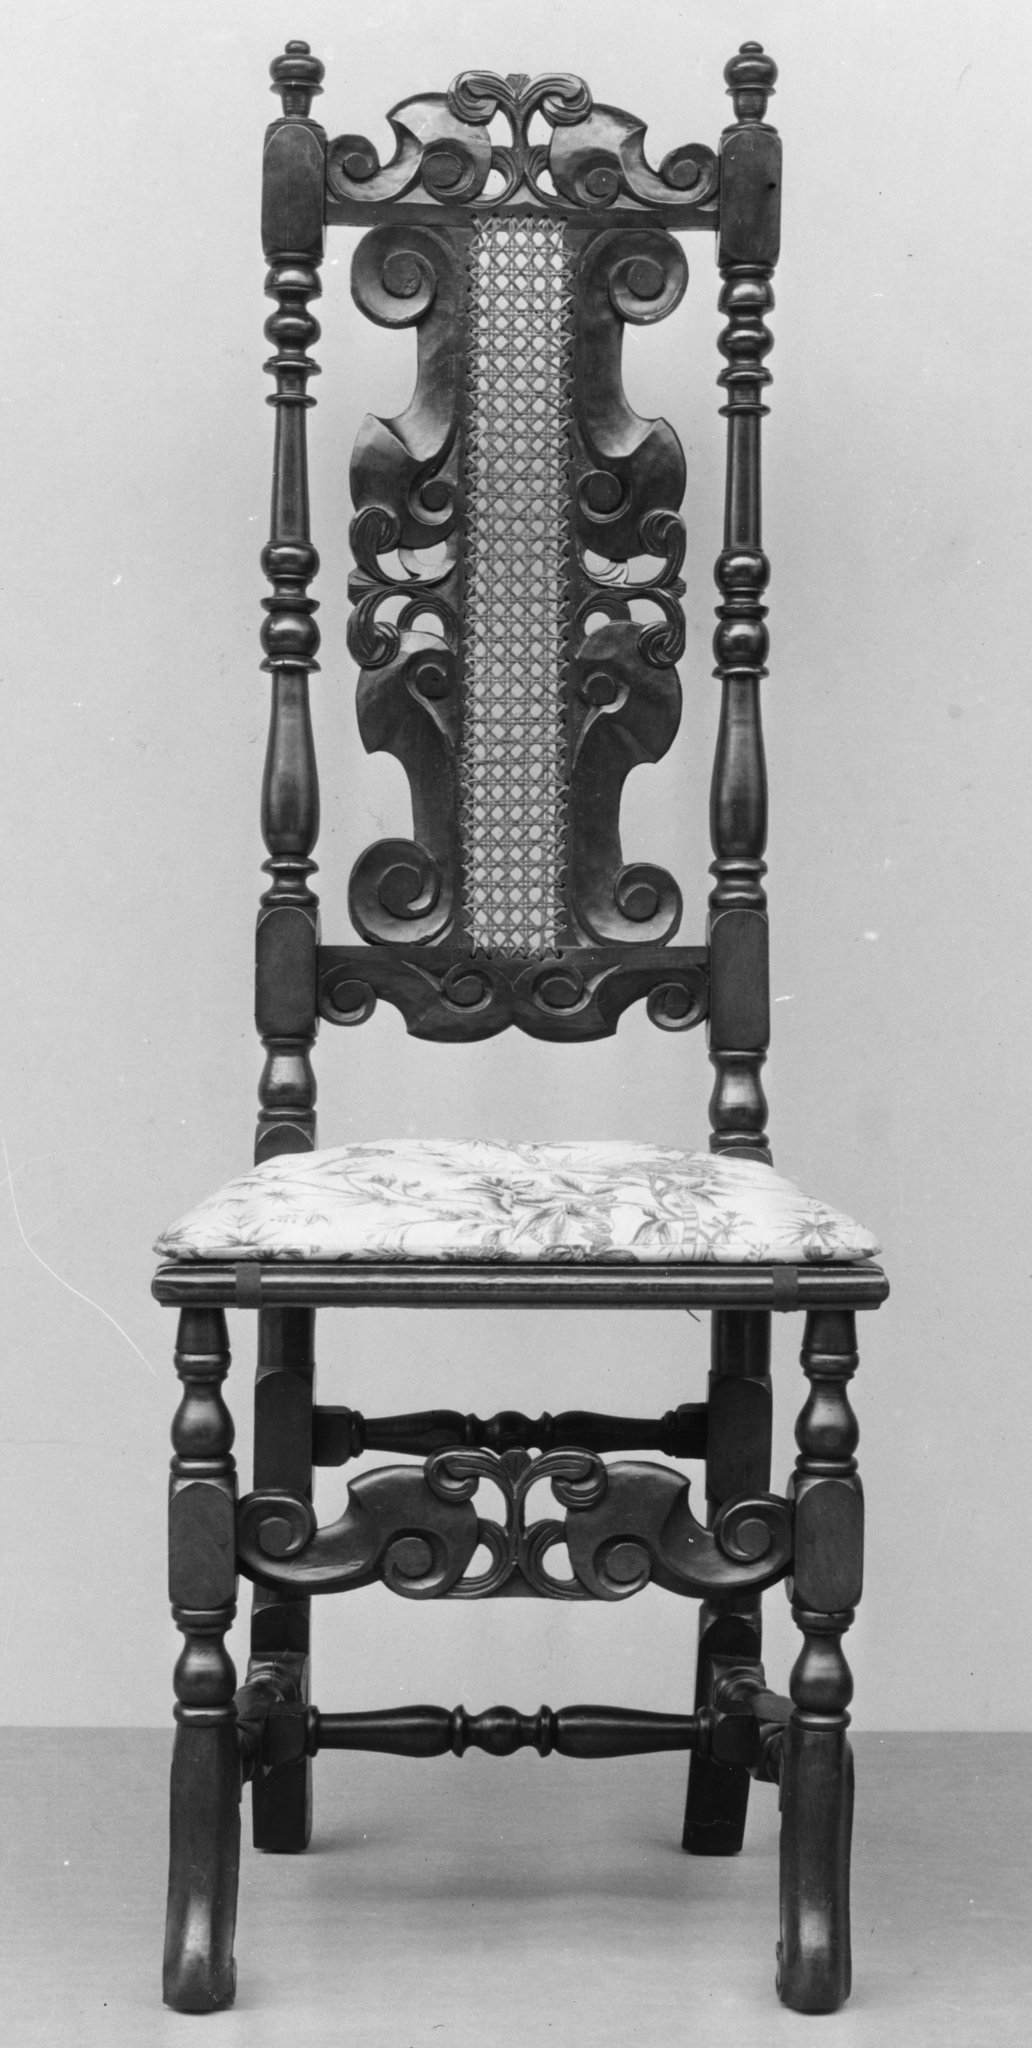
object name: side chair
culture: british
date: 1690-1710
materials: wood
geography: england